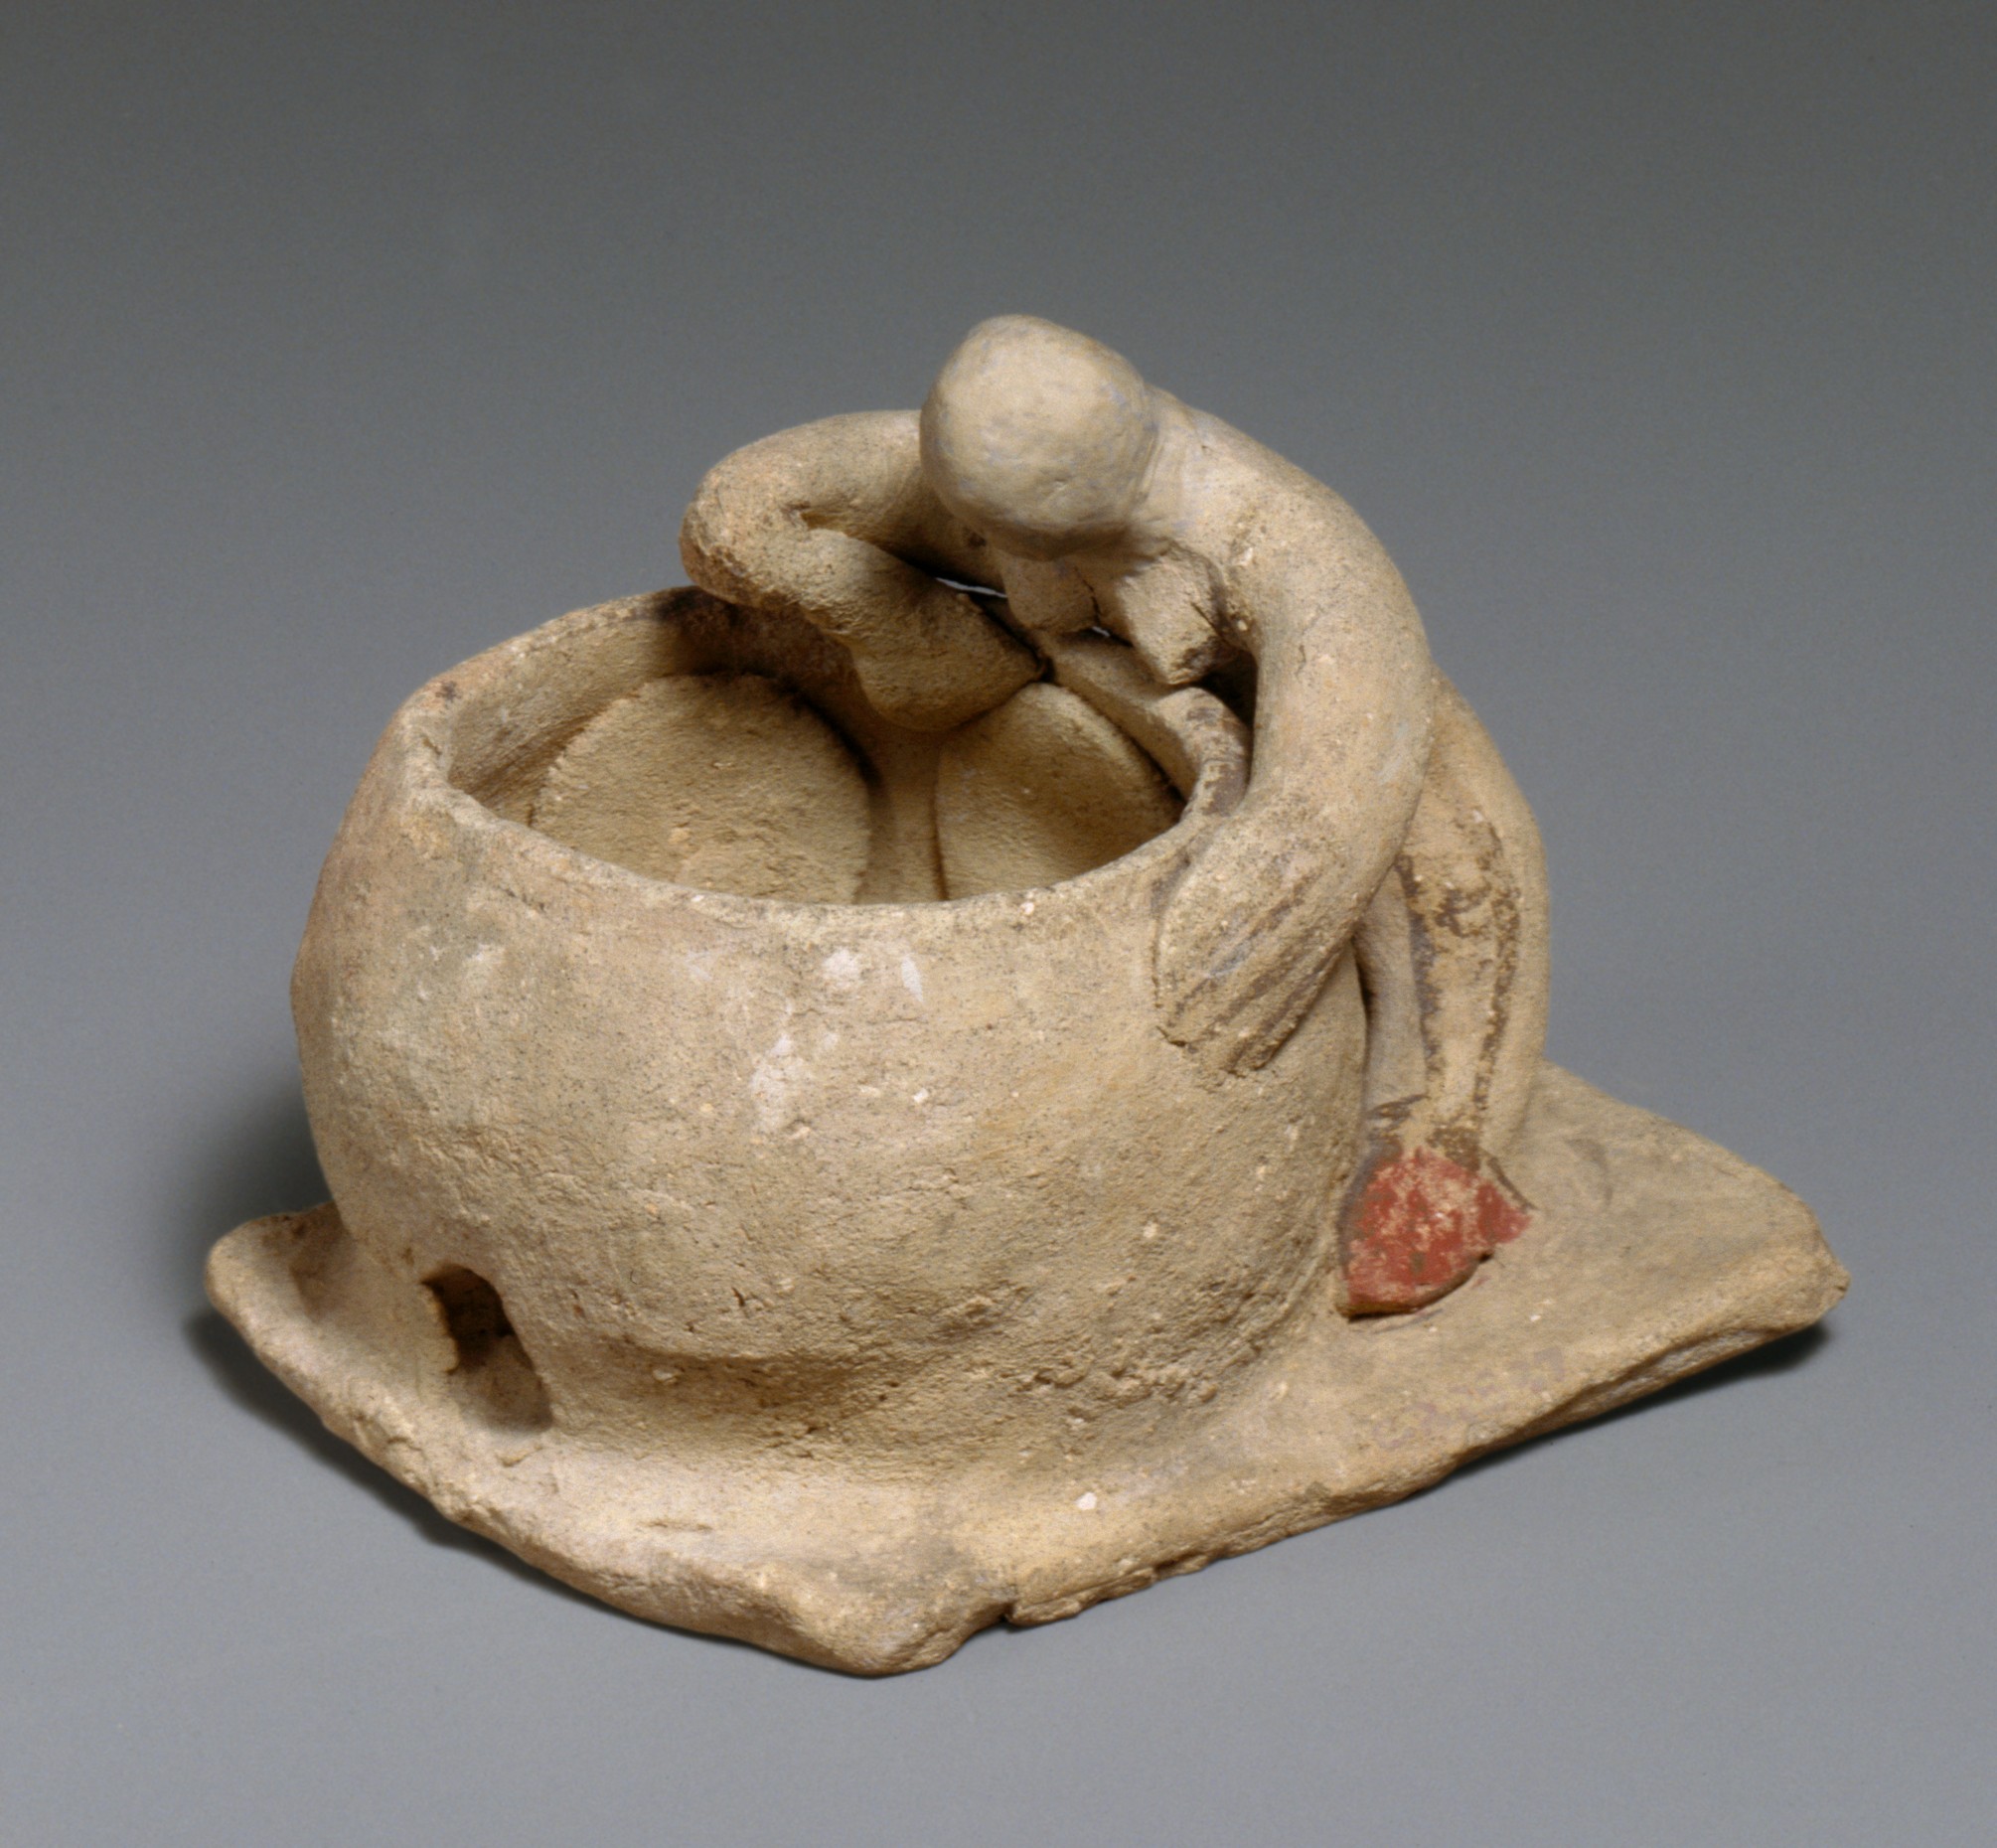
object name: statuette of a woman baking bread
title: Terracotta woman baking bread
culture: cypriot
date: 600-480 BCE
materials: terracotta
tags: food,bread,women,cooking